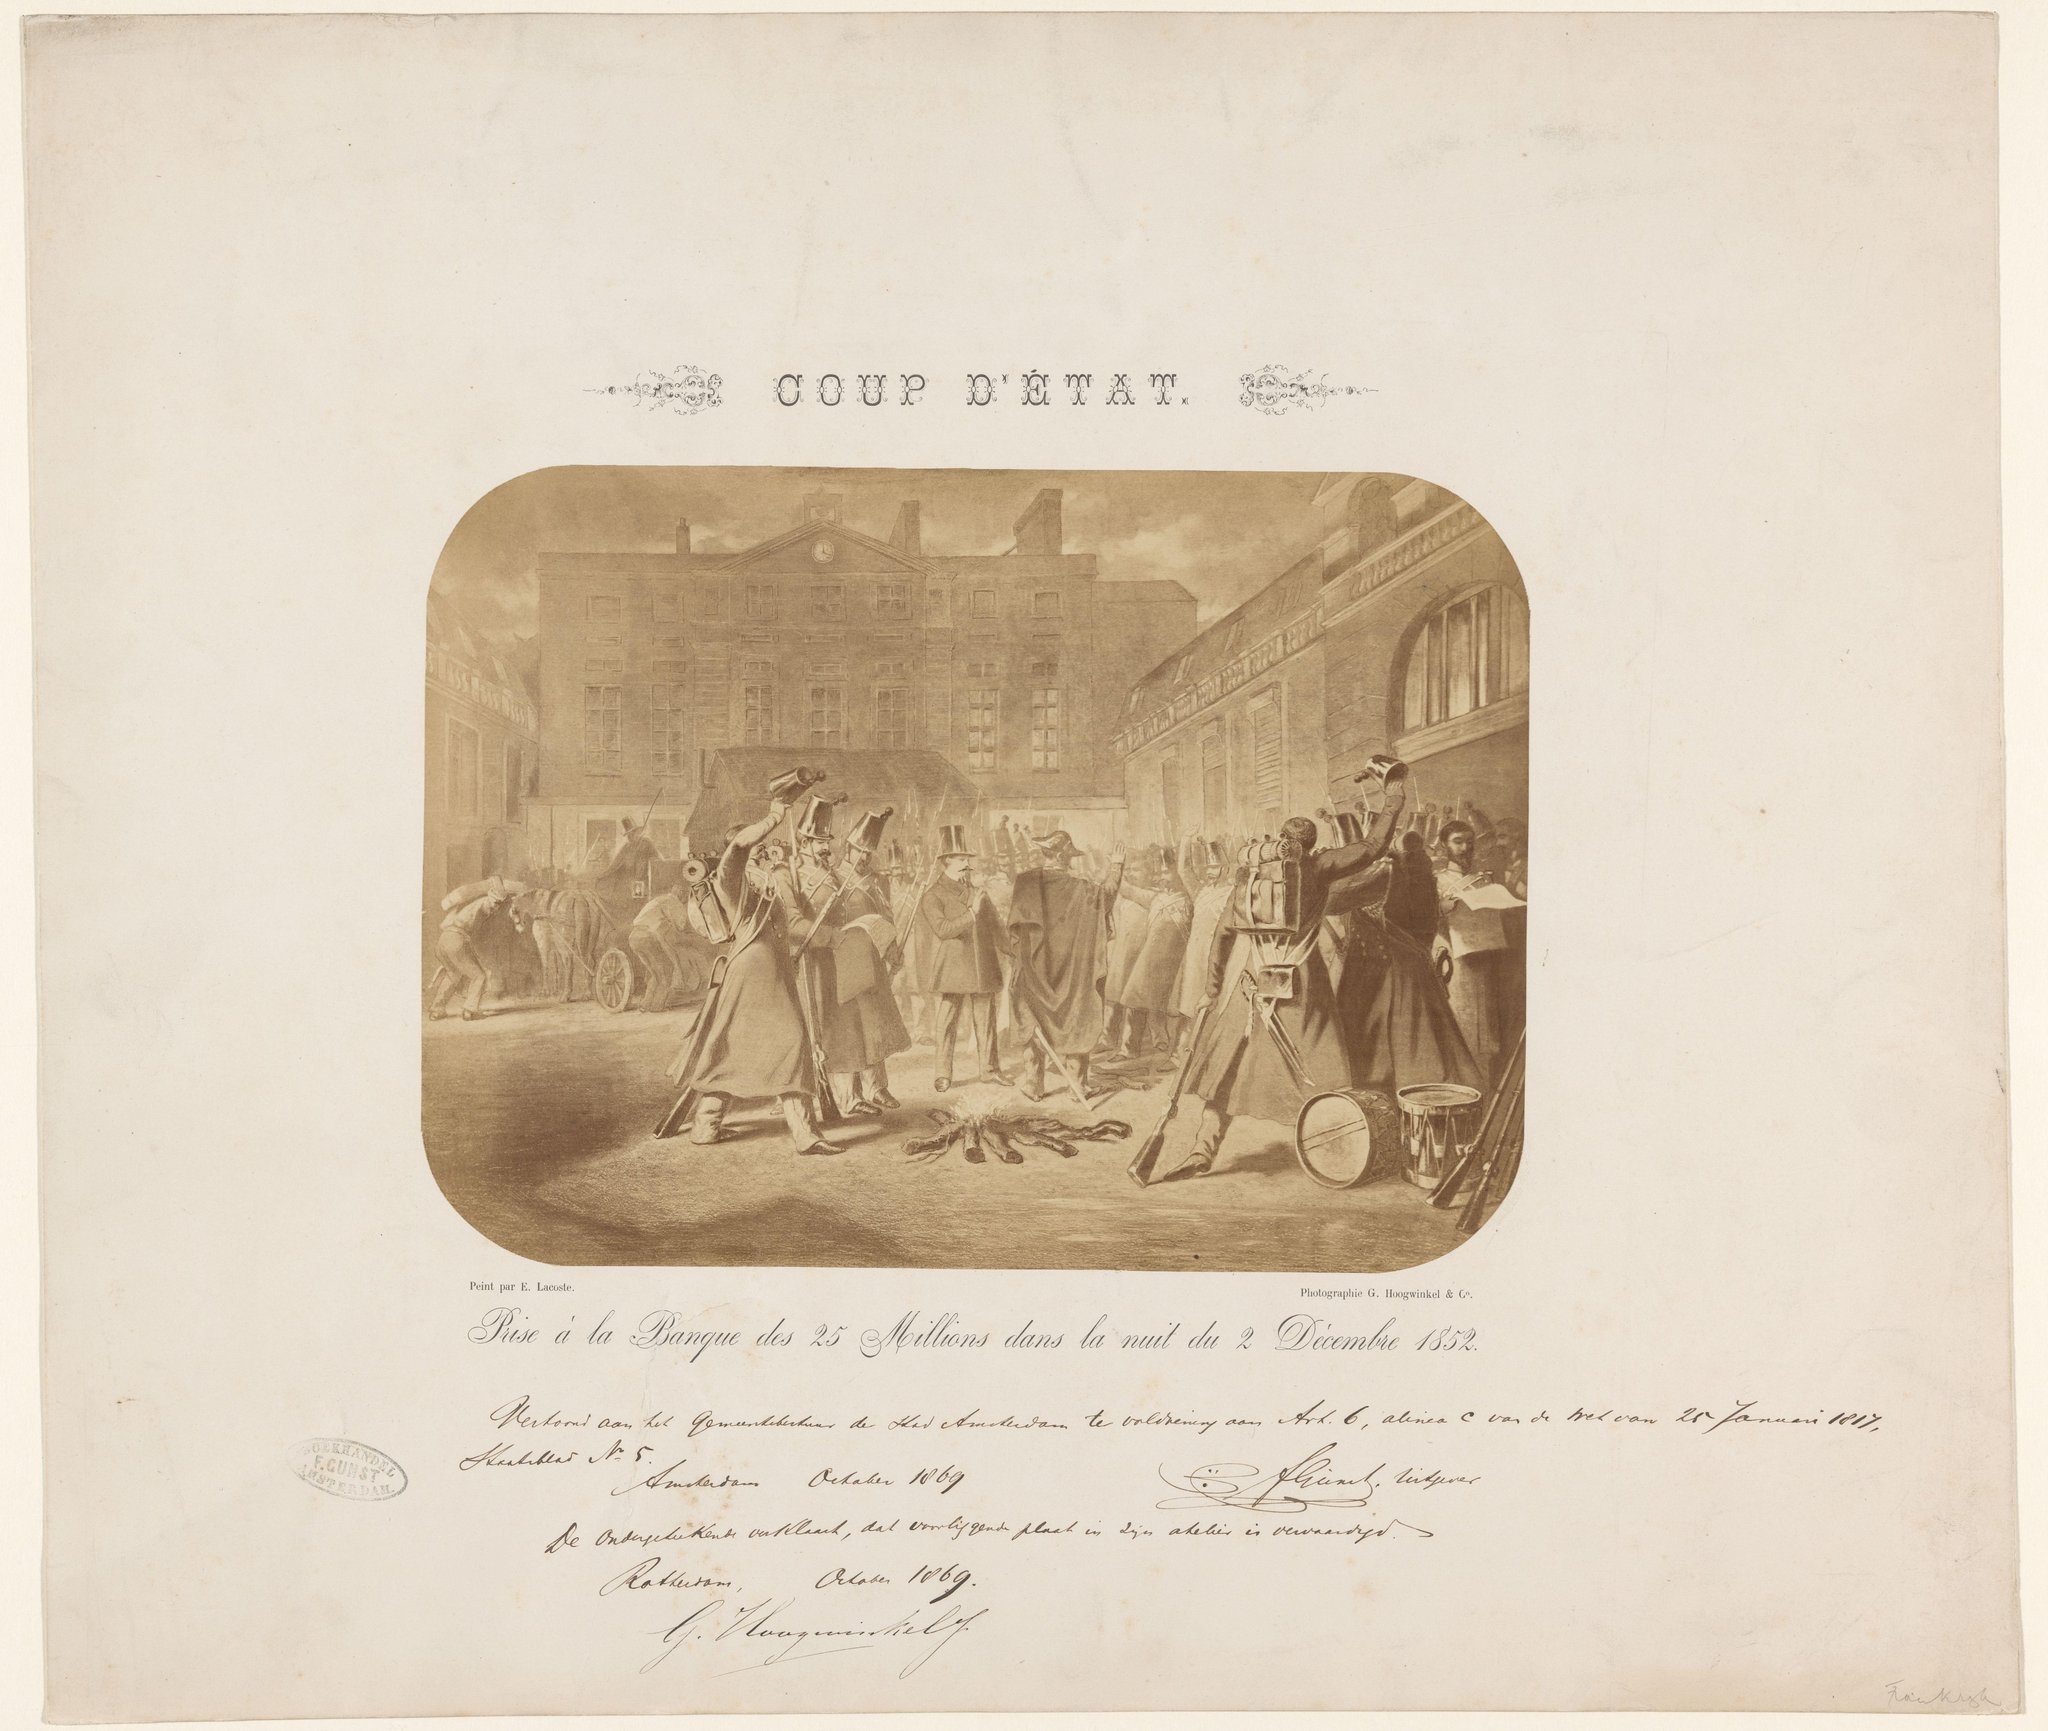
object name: photograph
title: Bankroof op 2 december 1852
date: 1810-1869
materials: paper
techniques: photography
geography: amsterdam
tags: london, napoleon iii (keizer der fransen), soldiers in gay company, robbery, revolution, revolt, picture, painting, paris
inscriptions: collector's mark: Lugt 2228, workshop stamp: ‘Boekhandel F. Gunst Amsterdam’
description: Schilderij van een groep feestende en drinkende soldaten op straat rond een houtvuurtje. Volgens het opschrift gaat het om een bankroof op 2 december 1852 waarbij 25 miljoen francs werd buitgemaakt. De schilderij wordt ook beschreven als de viering van de staatsgreep van Napoleon III op 2 december 1852.